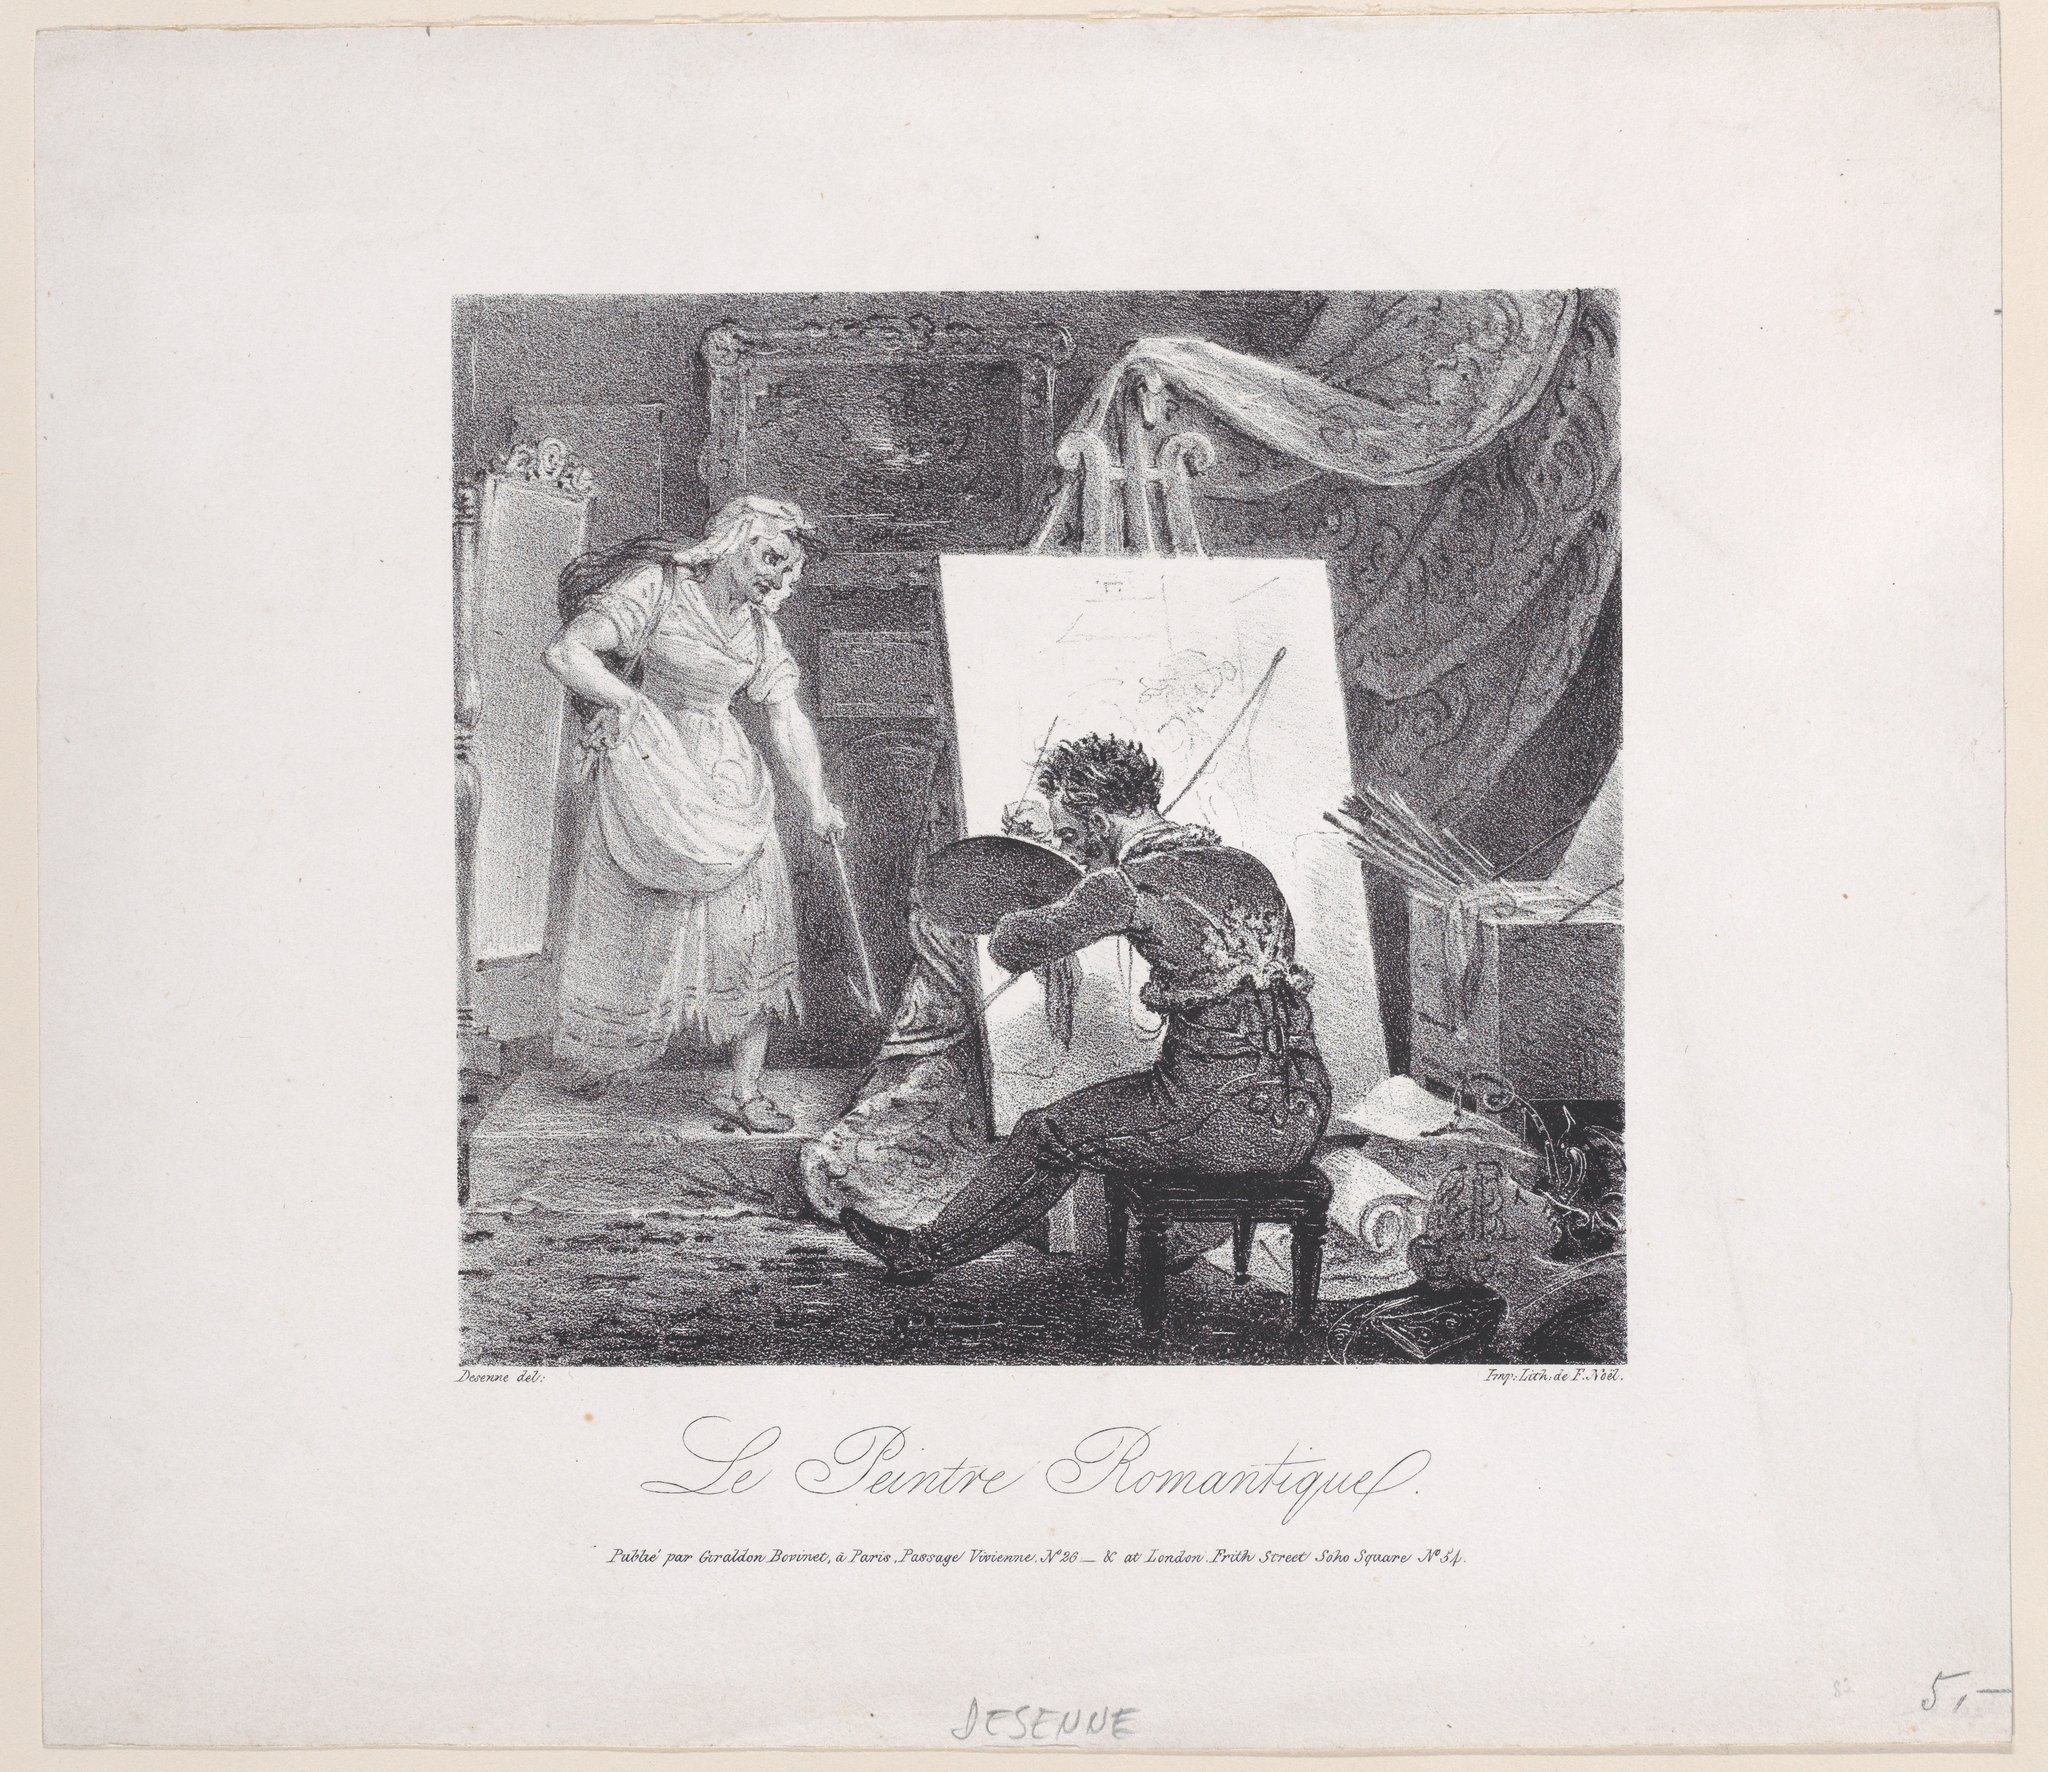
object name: print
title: The Romantic Painter (Le Peintre Romantique)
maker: alexandre joseph desenne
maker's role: artist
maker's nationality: french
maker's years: 1785-1827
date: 1805-1827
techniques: lithograph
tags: painting,men,women,artists